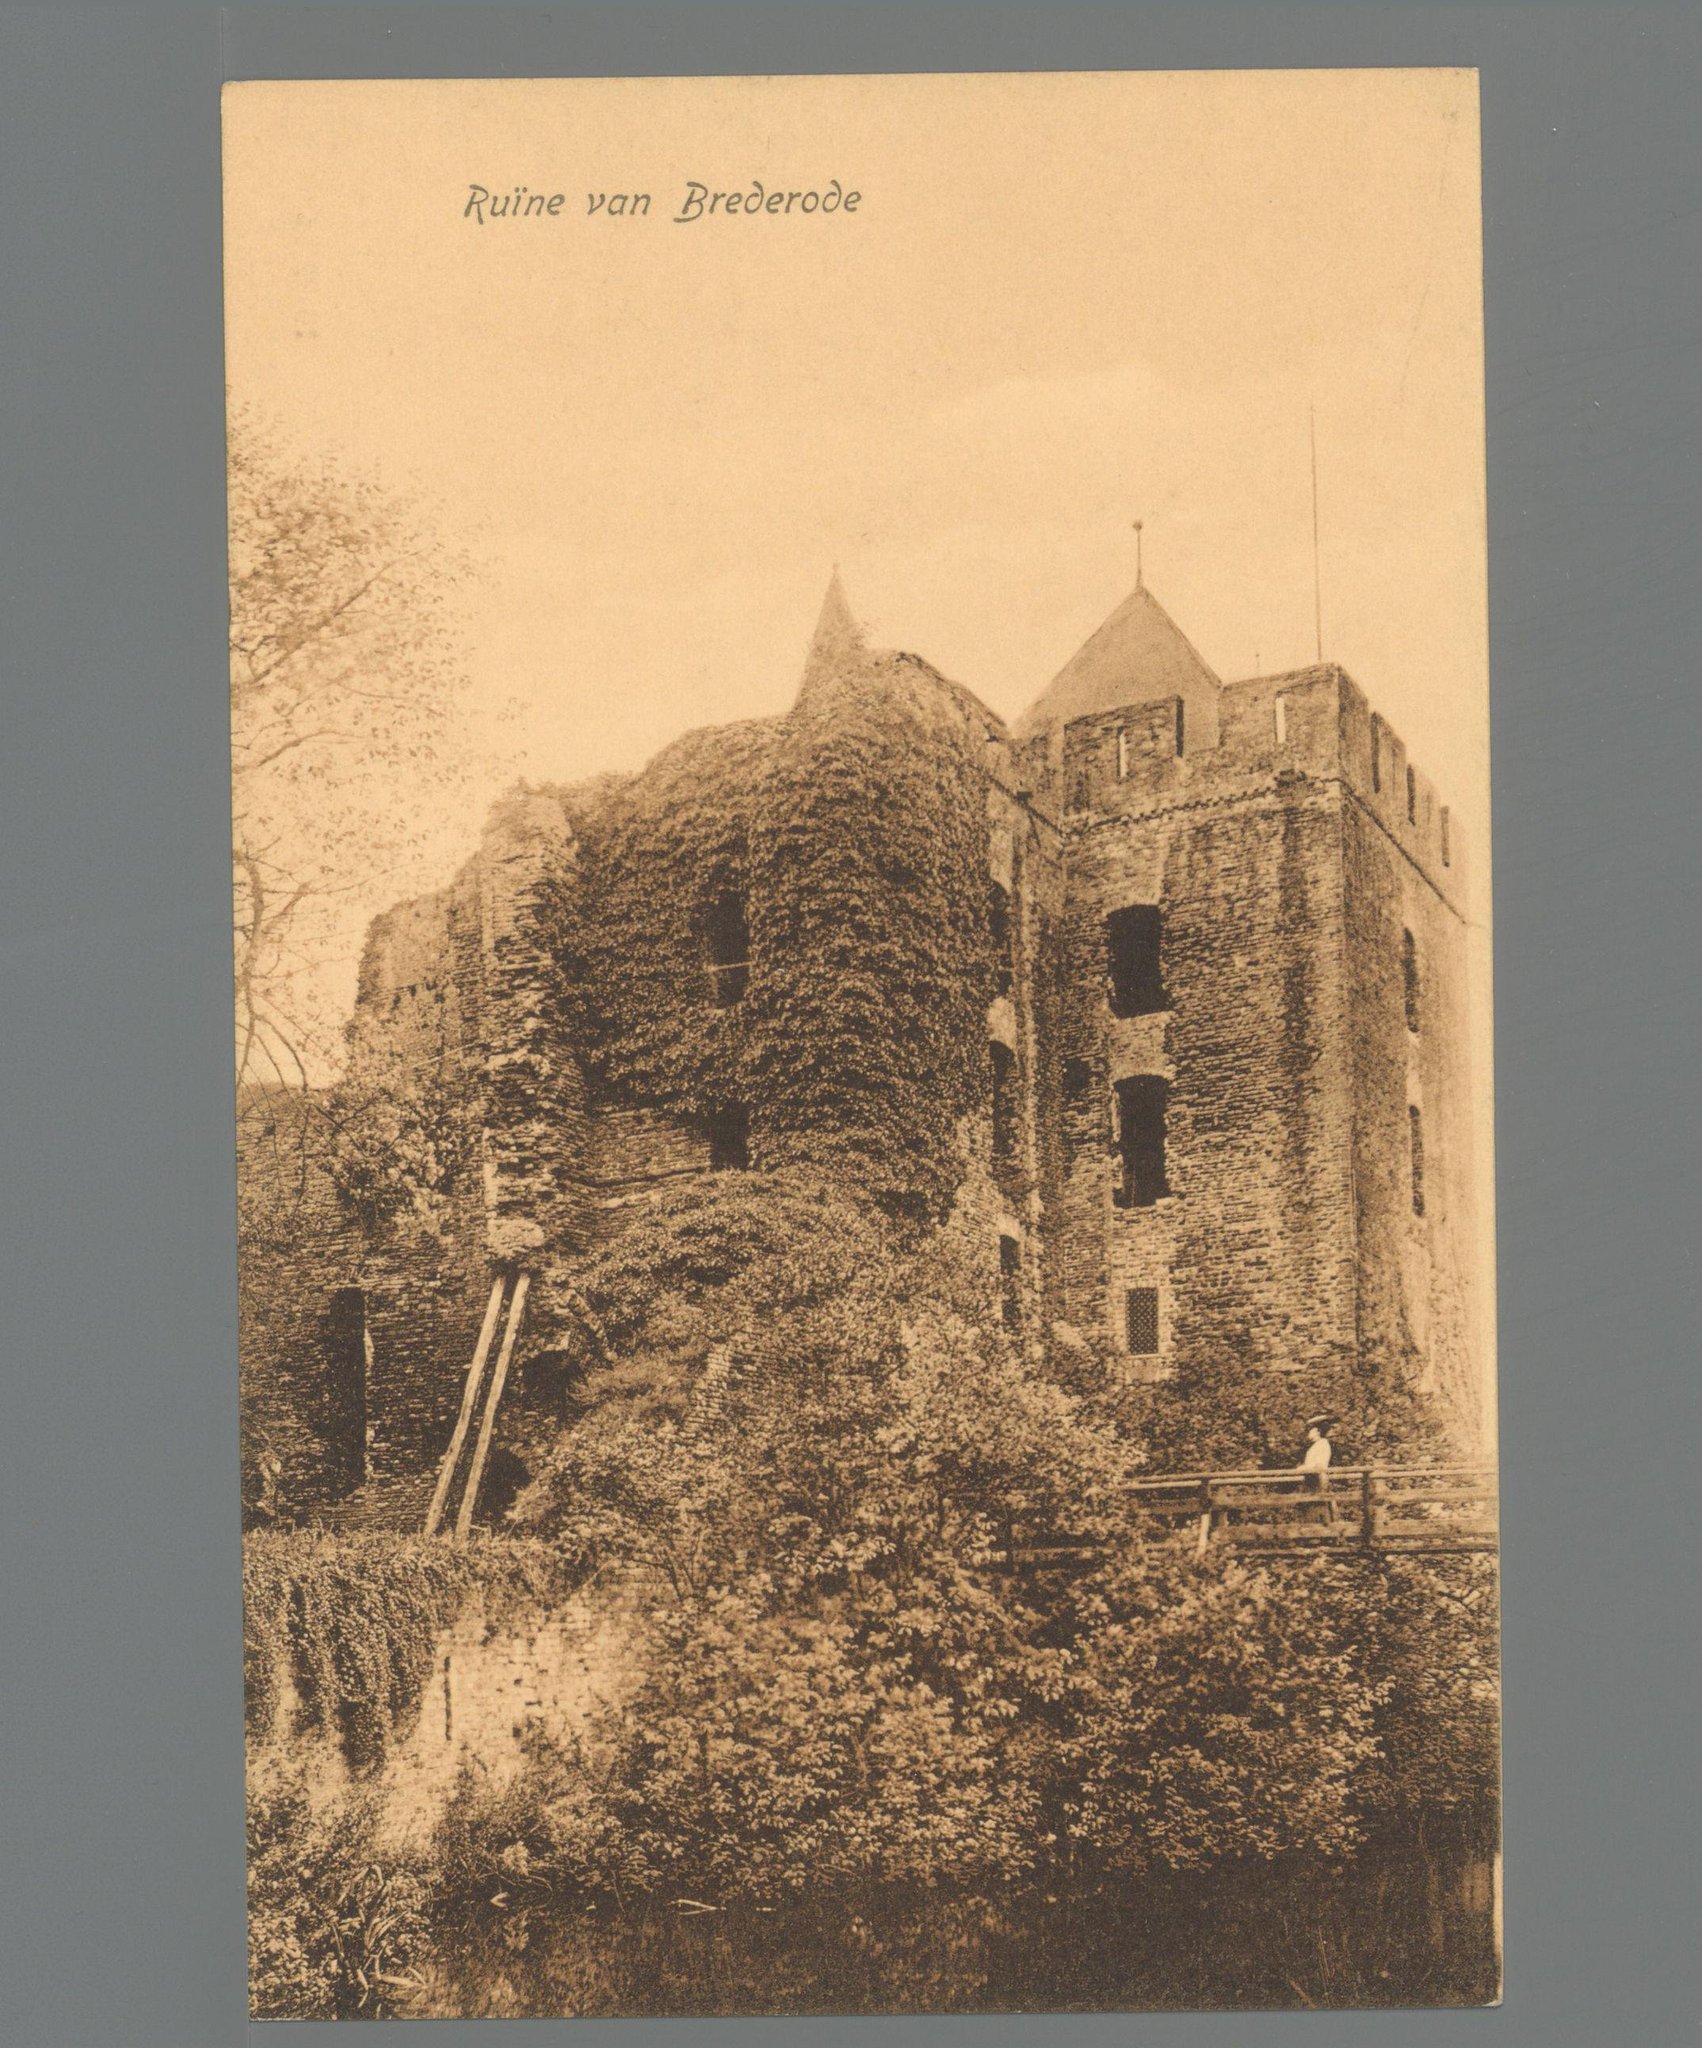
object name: photomechanical print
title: Ruïne van Brederode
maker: Anonymous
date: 1910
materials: cardboard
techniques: photograph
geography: leipzig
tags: castle, bridge in city across river, canal, etc.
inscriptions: date